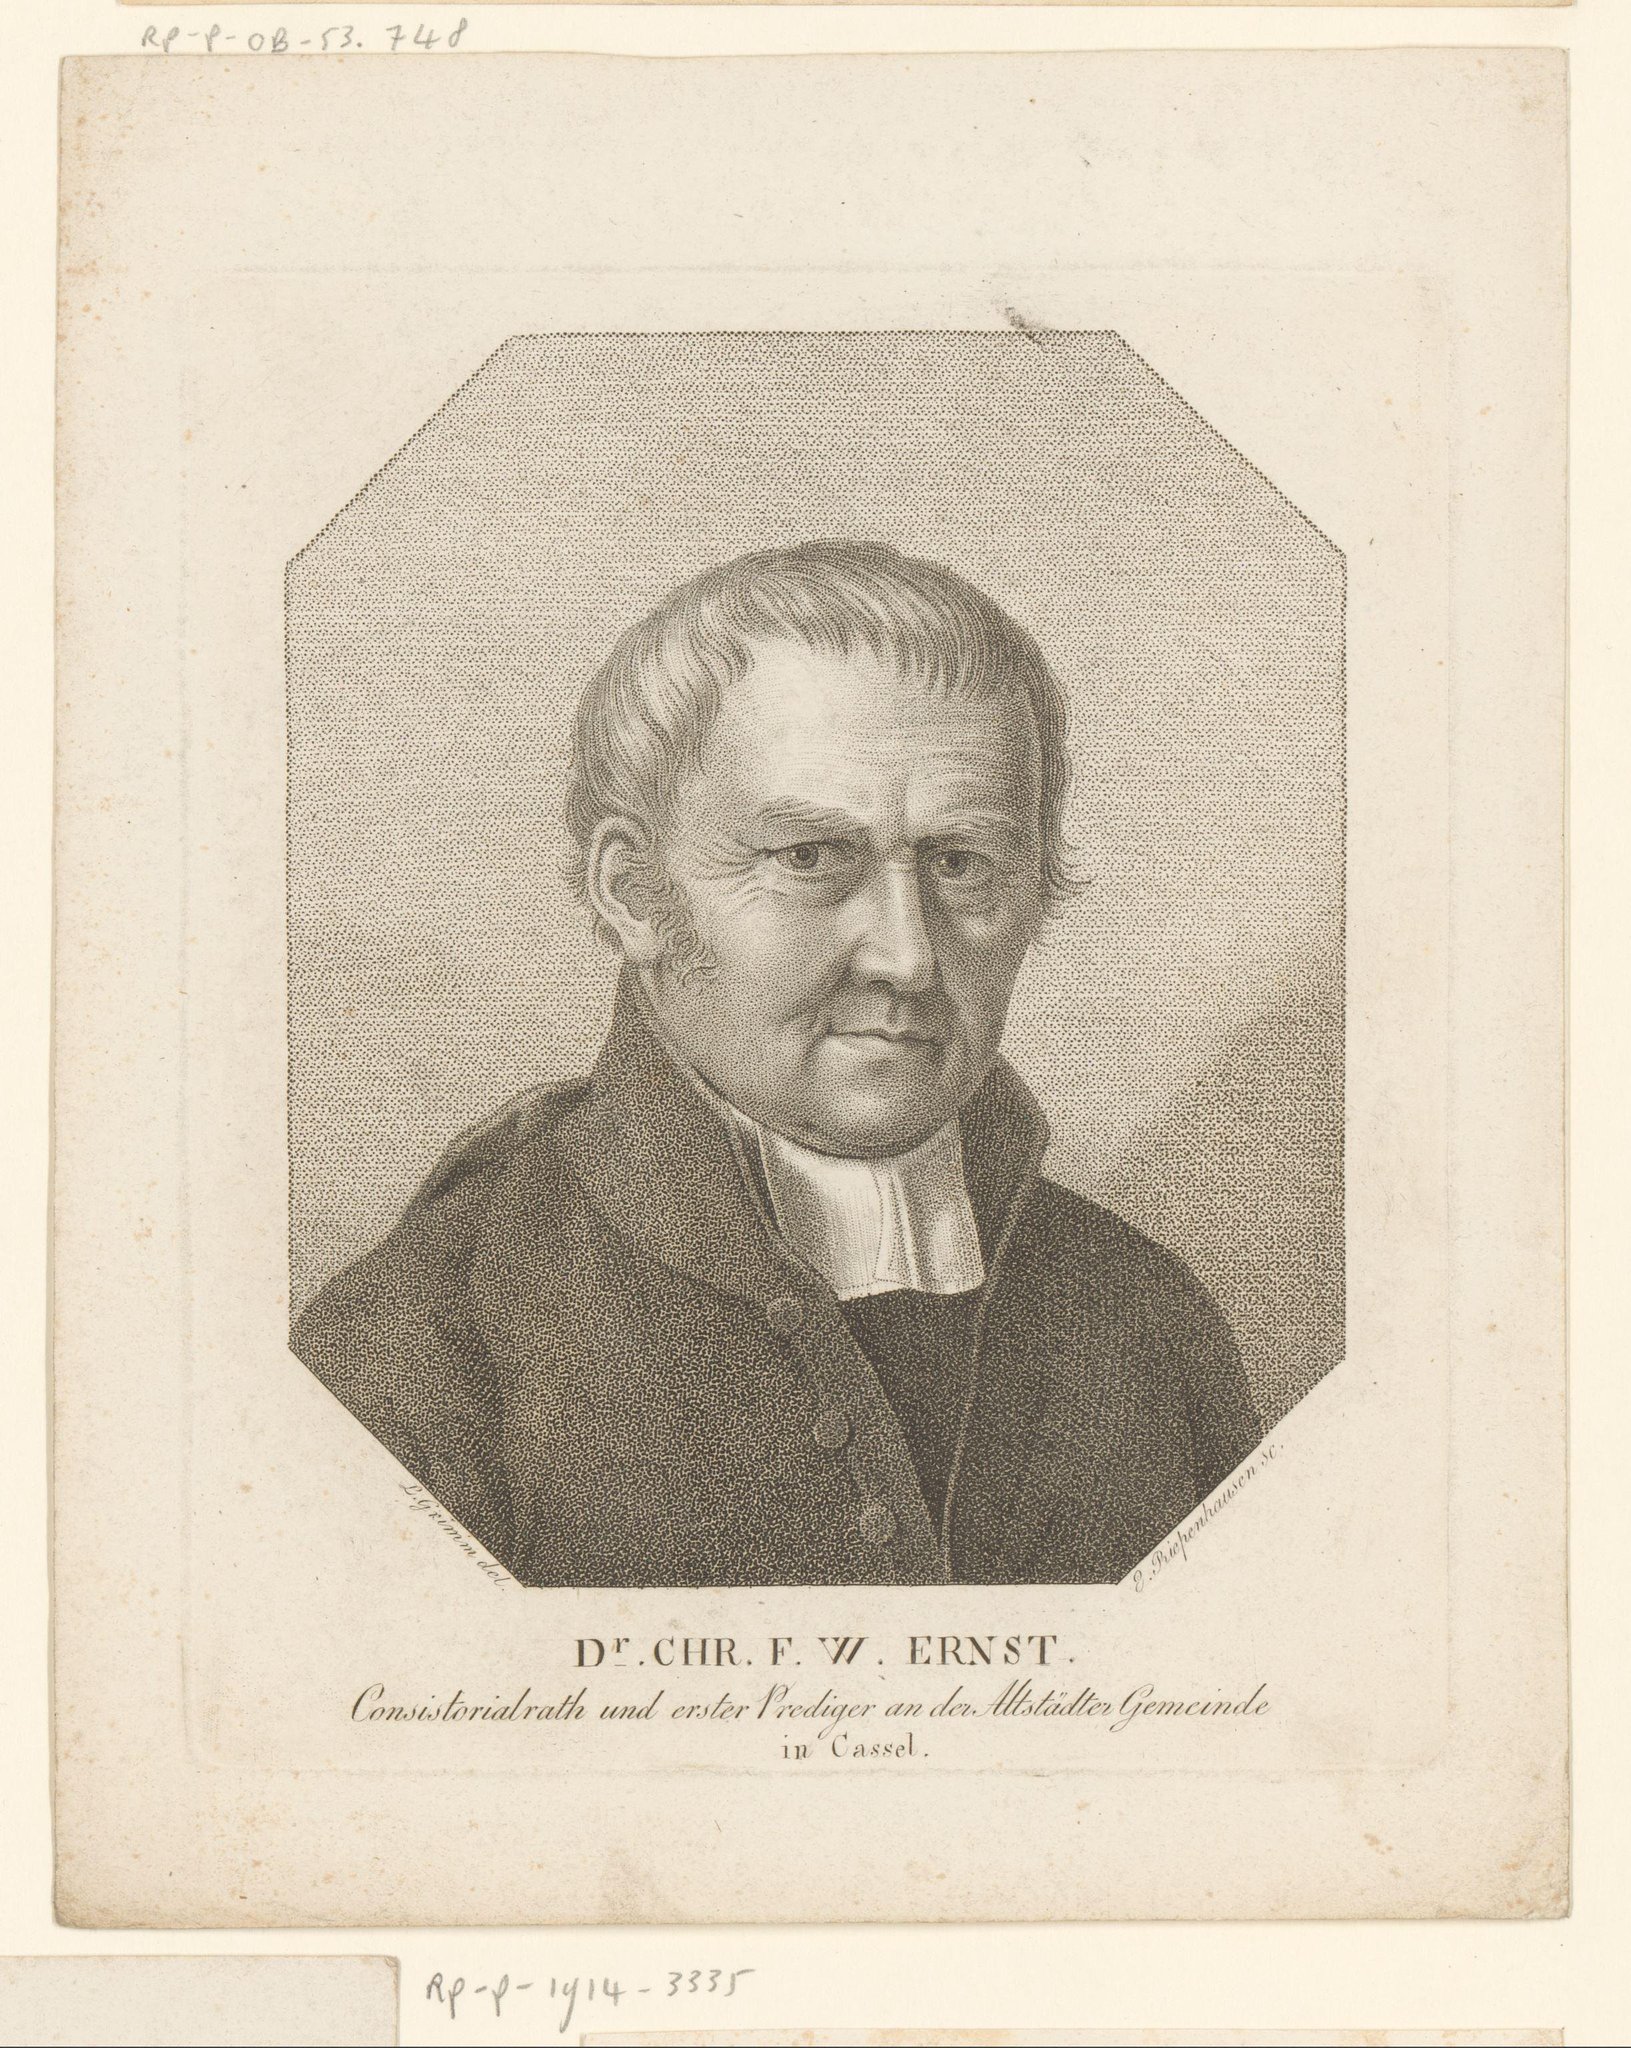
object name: print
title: Portret van Chr. F. W. Ernst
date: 1775-1840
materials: paper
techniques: stippling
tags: theologian, historical persons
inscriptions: collector's mark: Lugt 2228